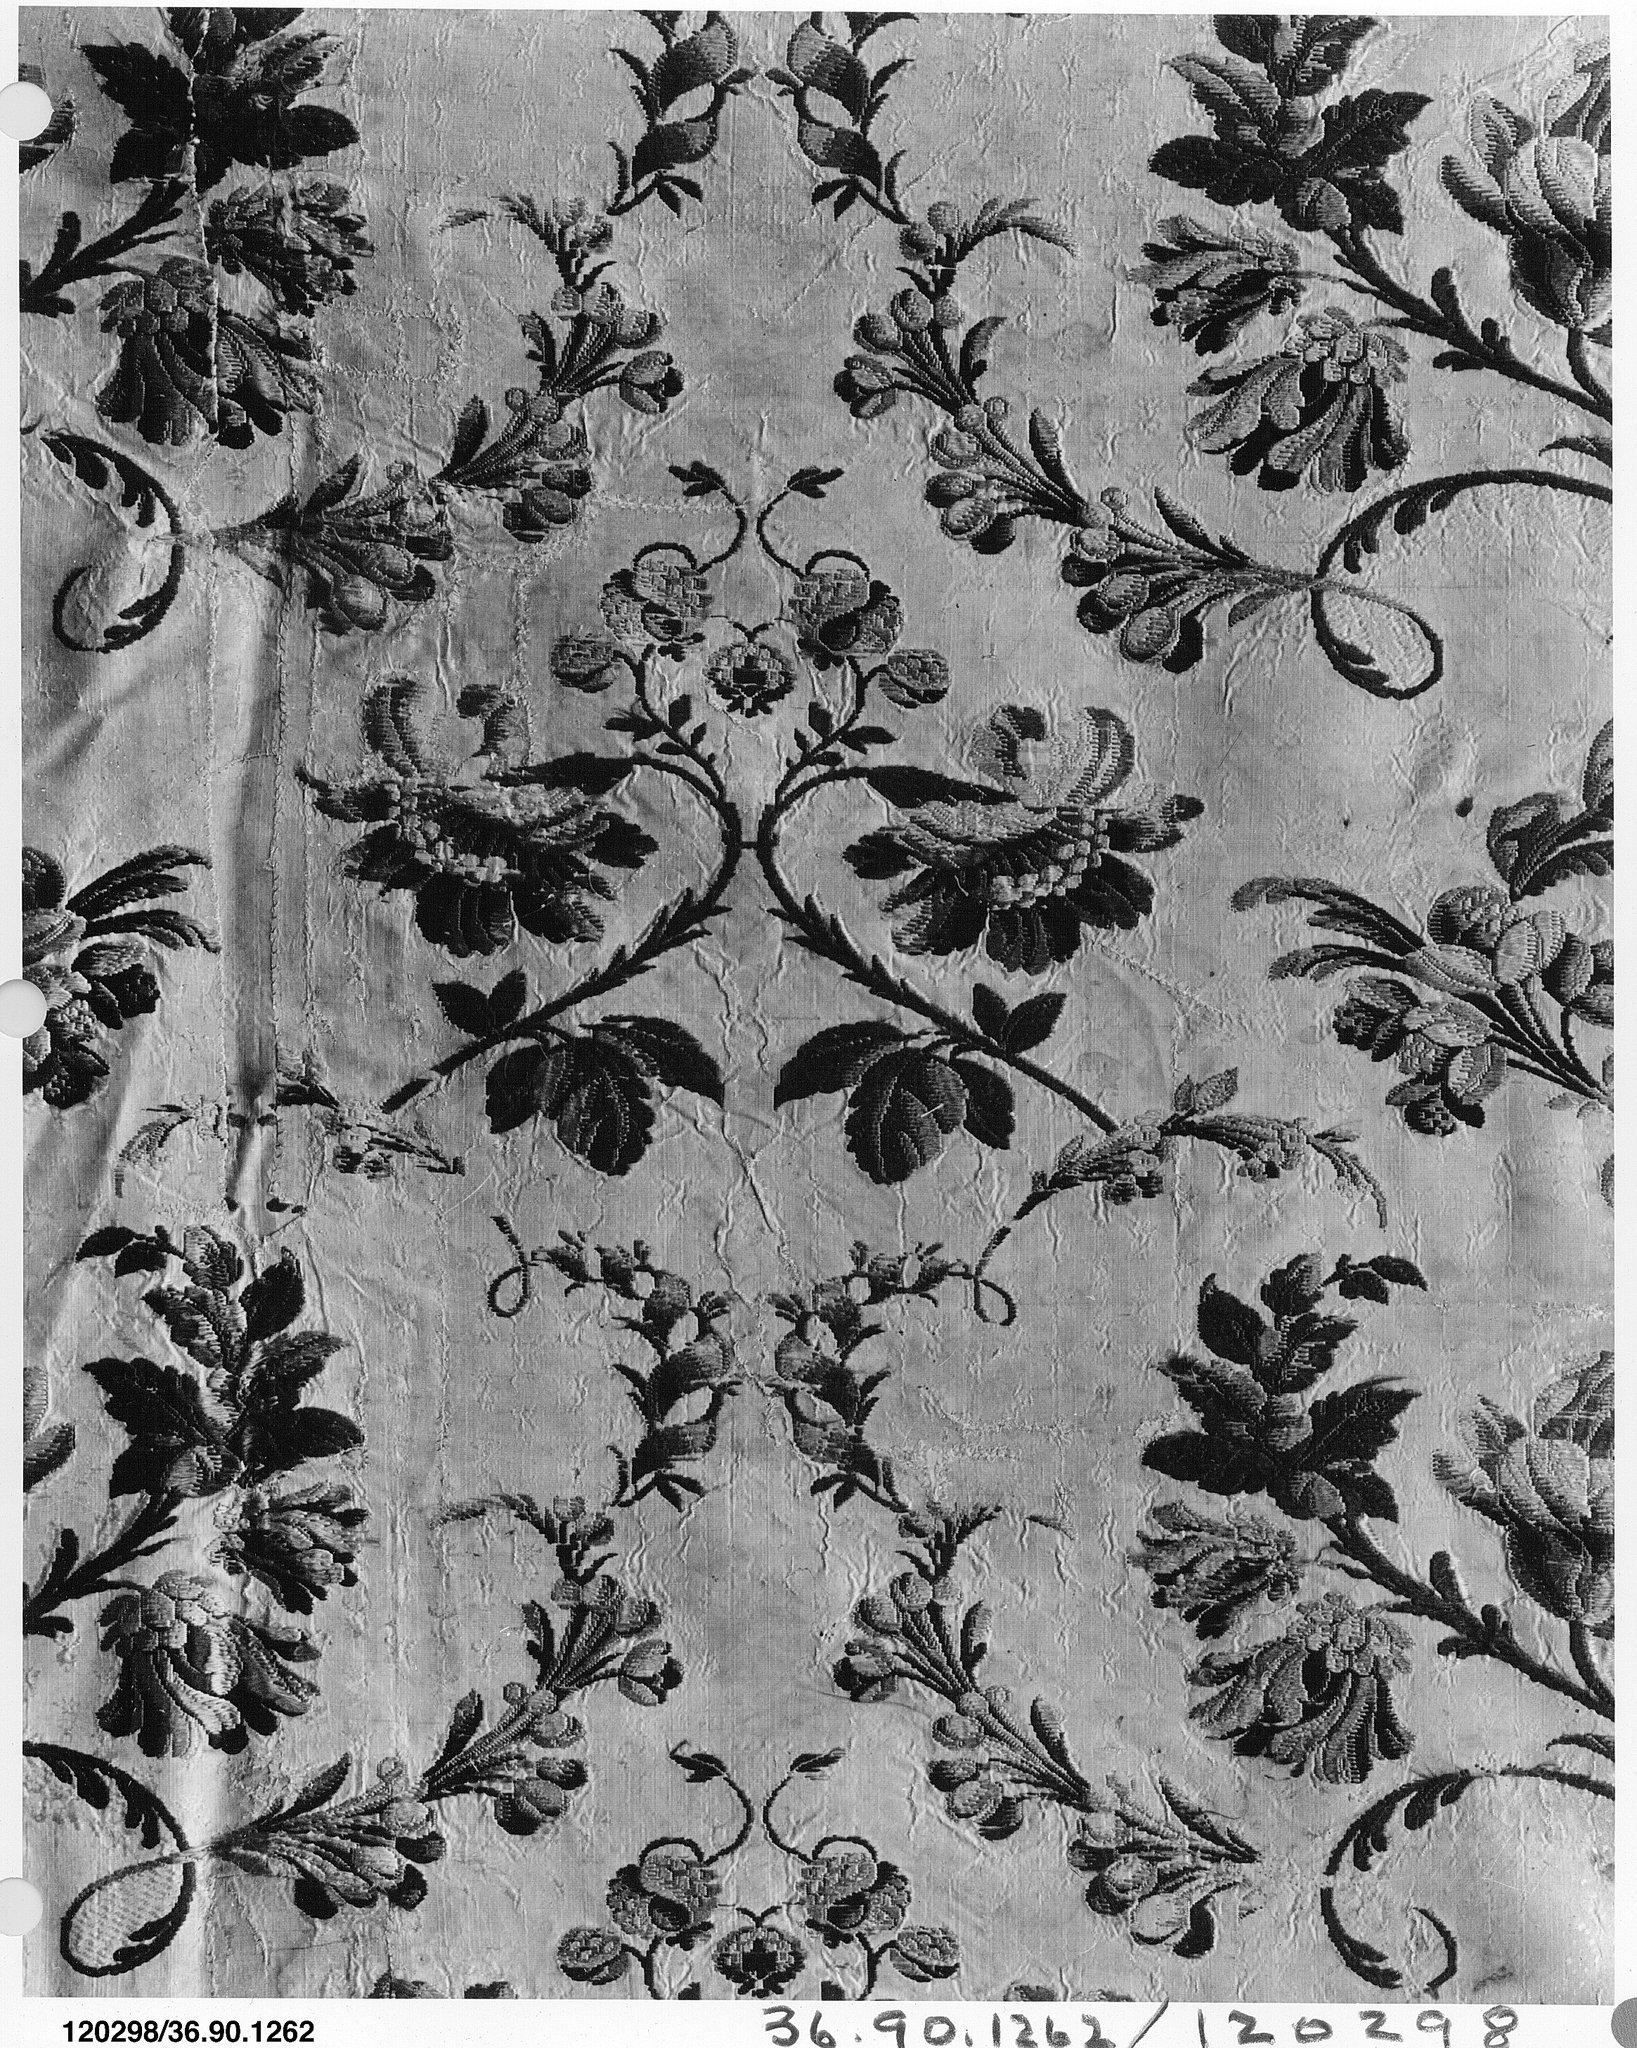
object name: piece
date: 1745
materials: silk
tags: flowers,leaves